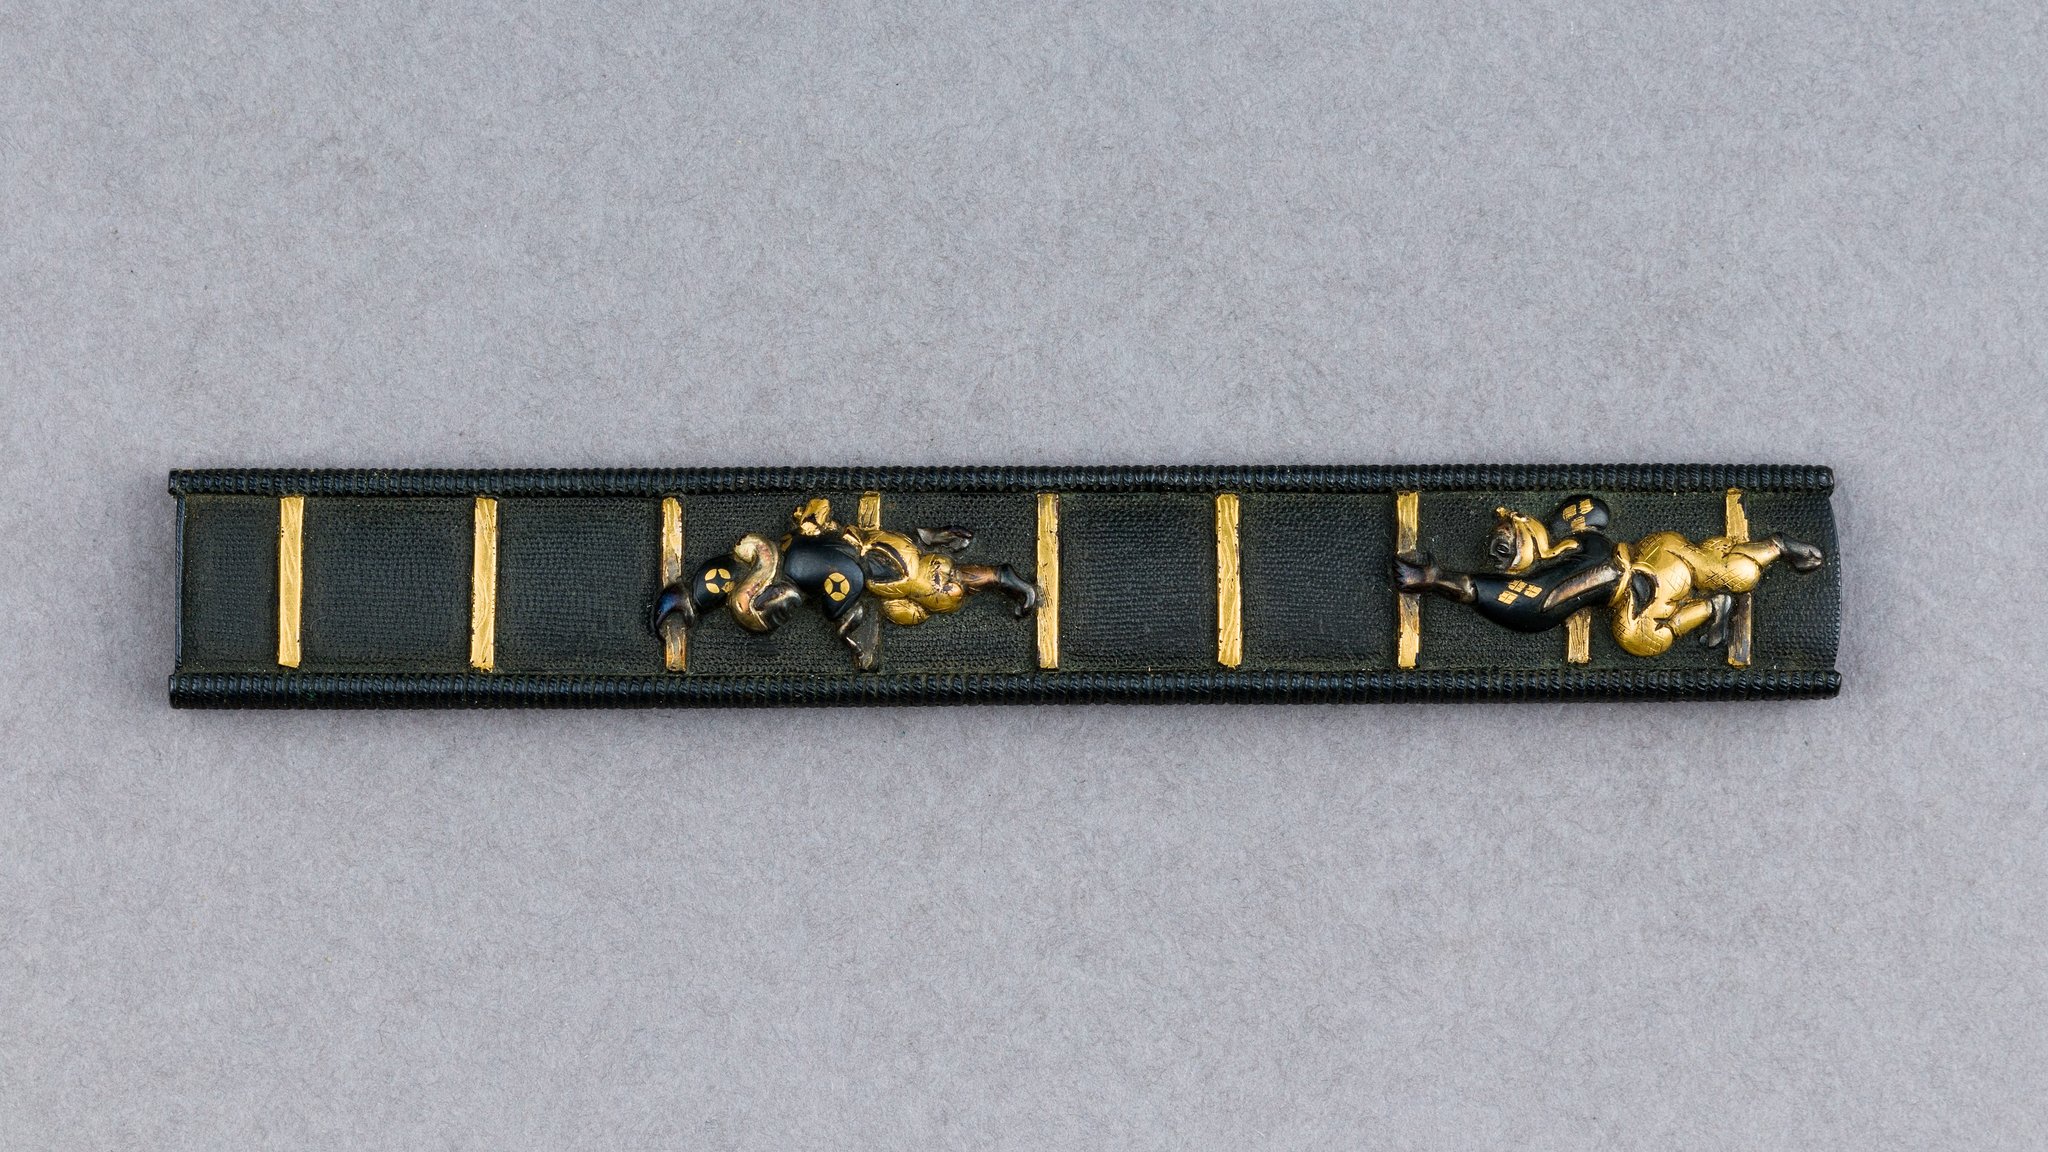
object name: knife handle kozuka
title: Knife Handle (Kozuka)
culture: japanese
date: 1615-1868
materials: gold alloy, gold, silver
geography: japan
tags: men